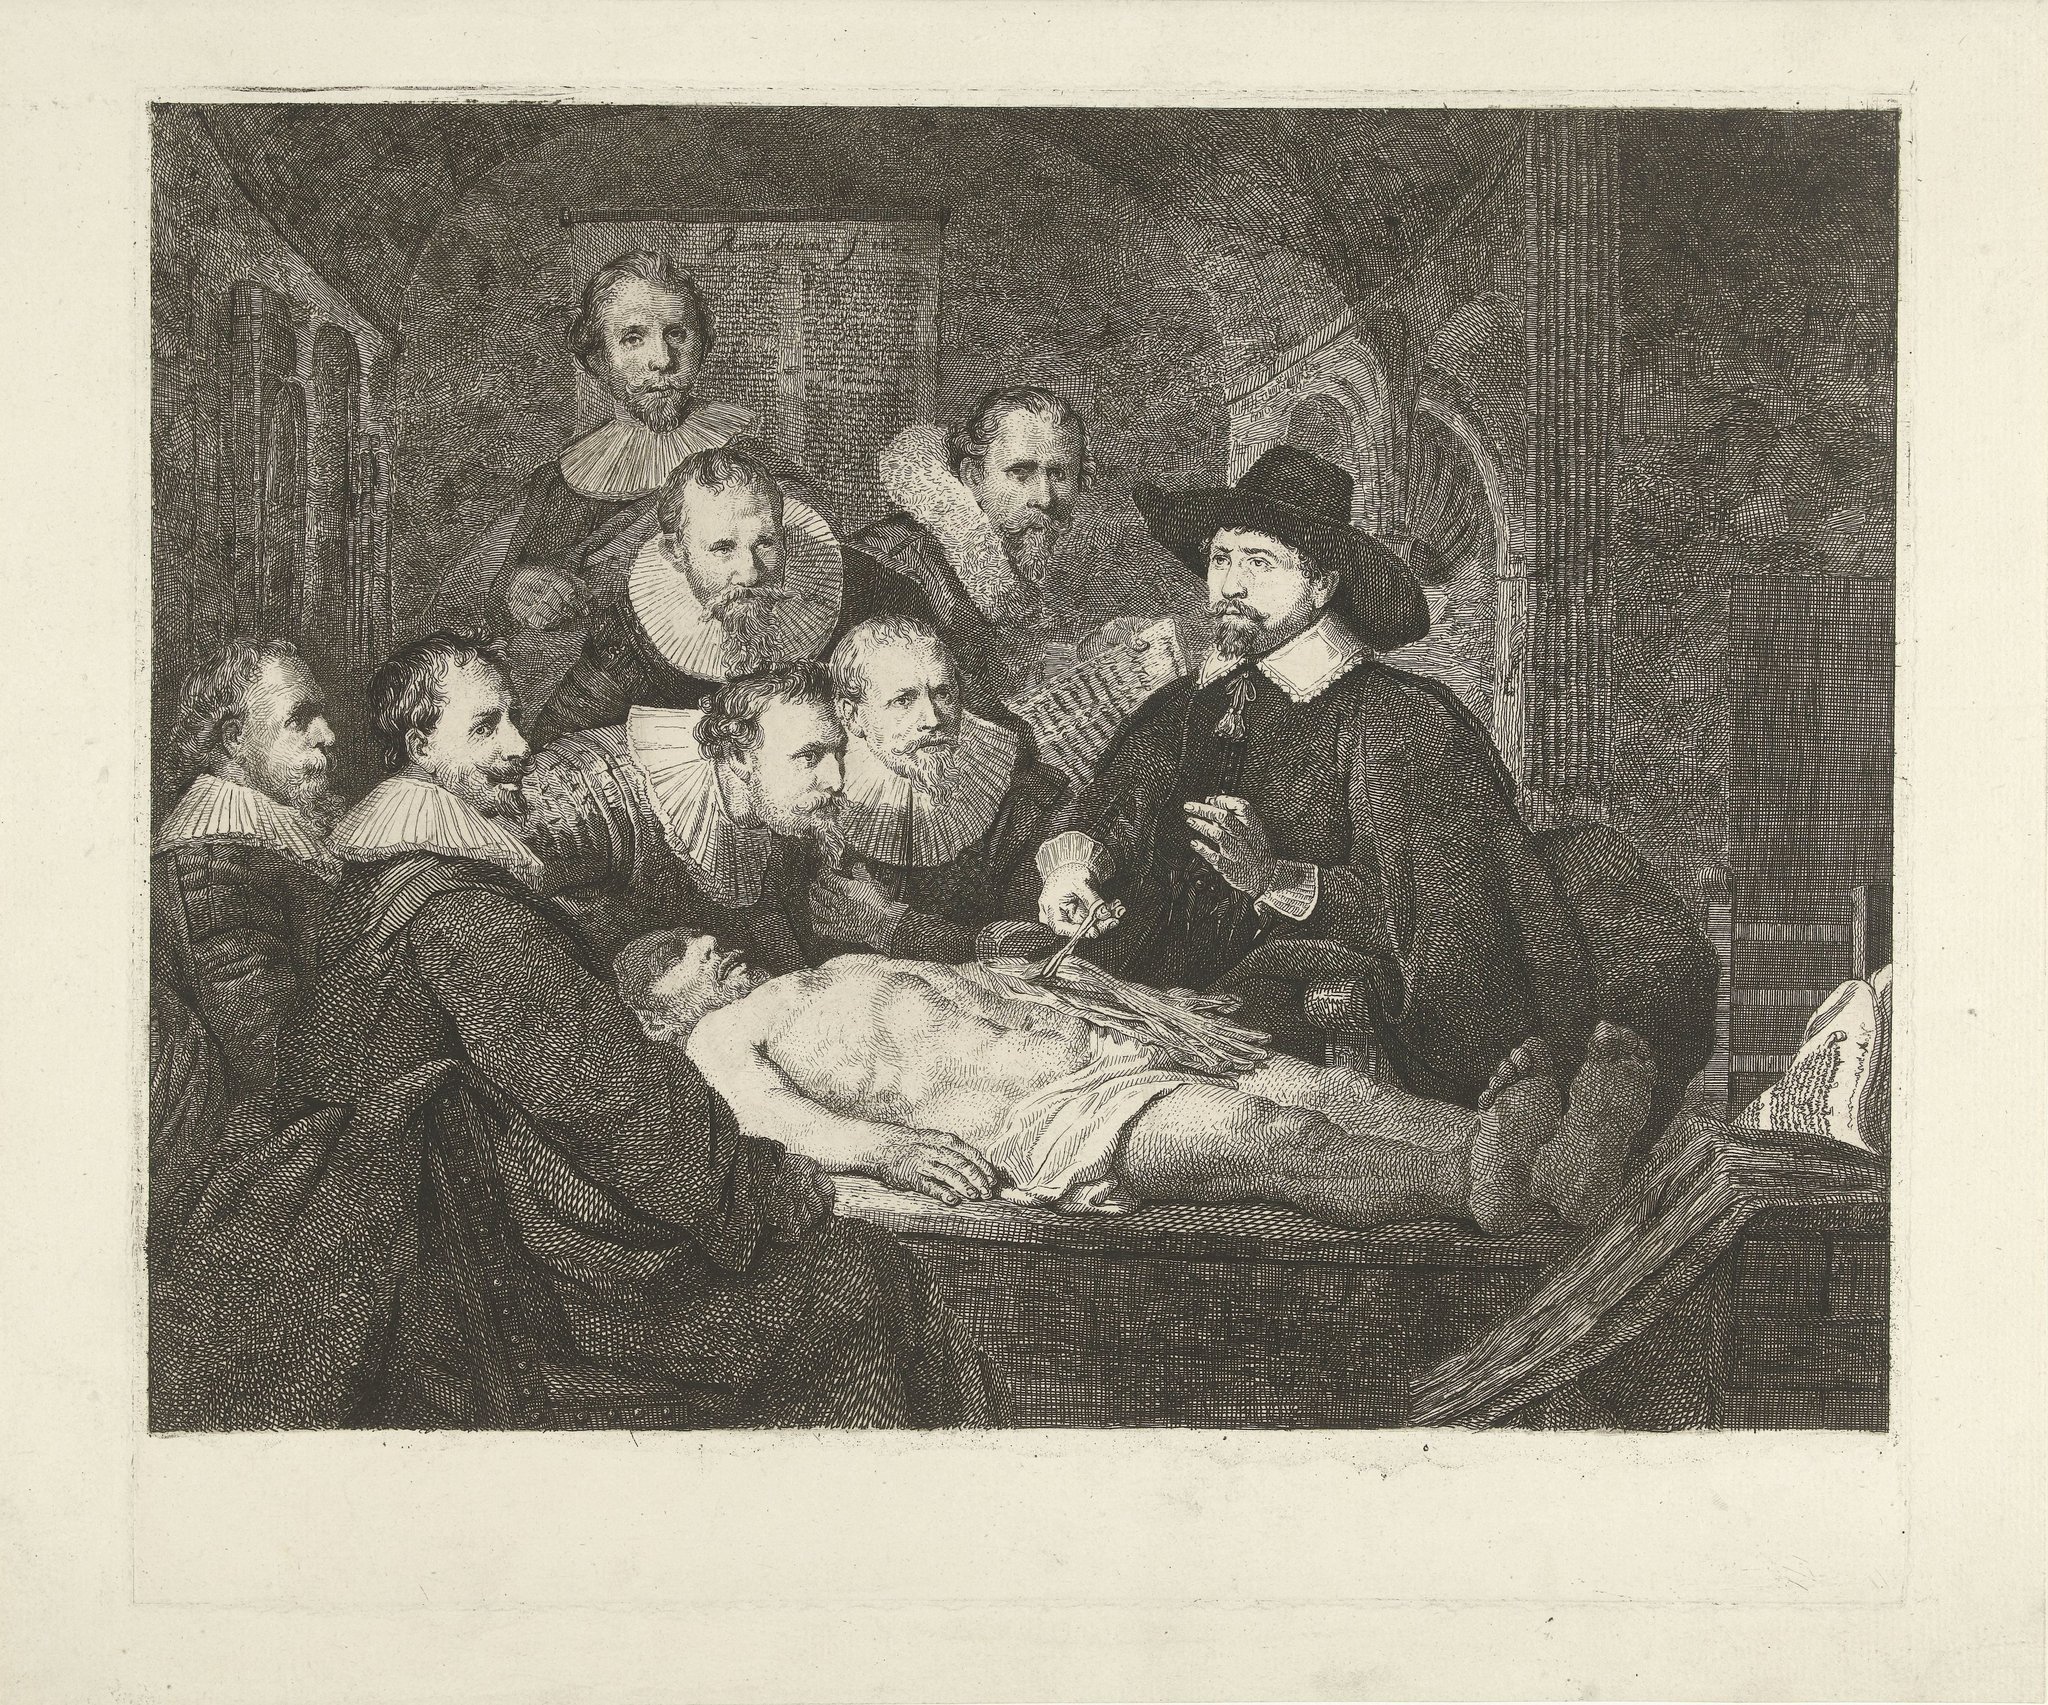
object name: print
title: Anatomische les van Dr. Nicolaes Tulp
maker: johannes pieter de frey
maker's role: draughtsman, print maker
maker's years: 1770-1834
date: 1798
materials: paper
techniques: etching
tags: the hague, mayor, historical persons, anatomy lesson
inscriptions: collector's mark: Lugt 12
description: Groepsportret van de Amsterdamse chirurgijns bij een anatomische les. De mannen zitten en staan rond een tafel waarop een lijk ligt. Dokter Nicolaes Tulp geeft onderricht. Hij heeft de arm van het lijk opengelegd en houdt met een tang een bundel armspieren omhoog, terwijl hij met zijn andere hand een demonstrerend gebaar maakt. Naast Nicolaes Tulp staan de chirurgen Jacob Blok, Hartman Hartmansz., Adraen Slabran, Jacob de Witt, Mathijs Kalkoen, Jacob Koolvelt en Frans van Loenen afgebeeld.